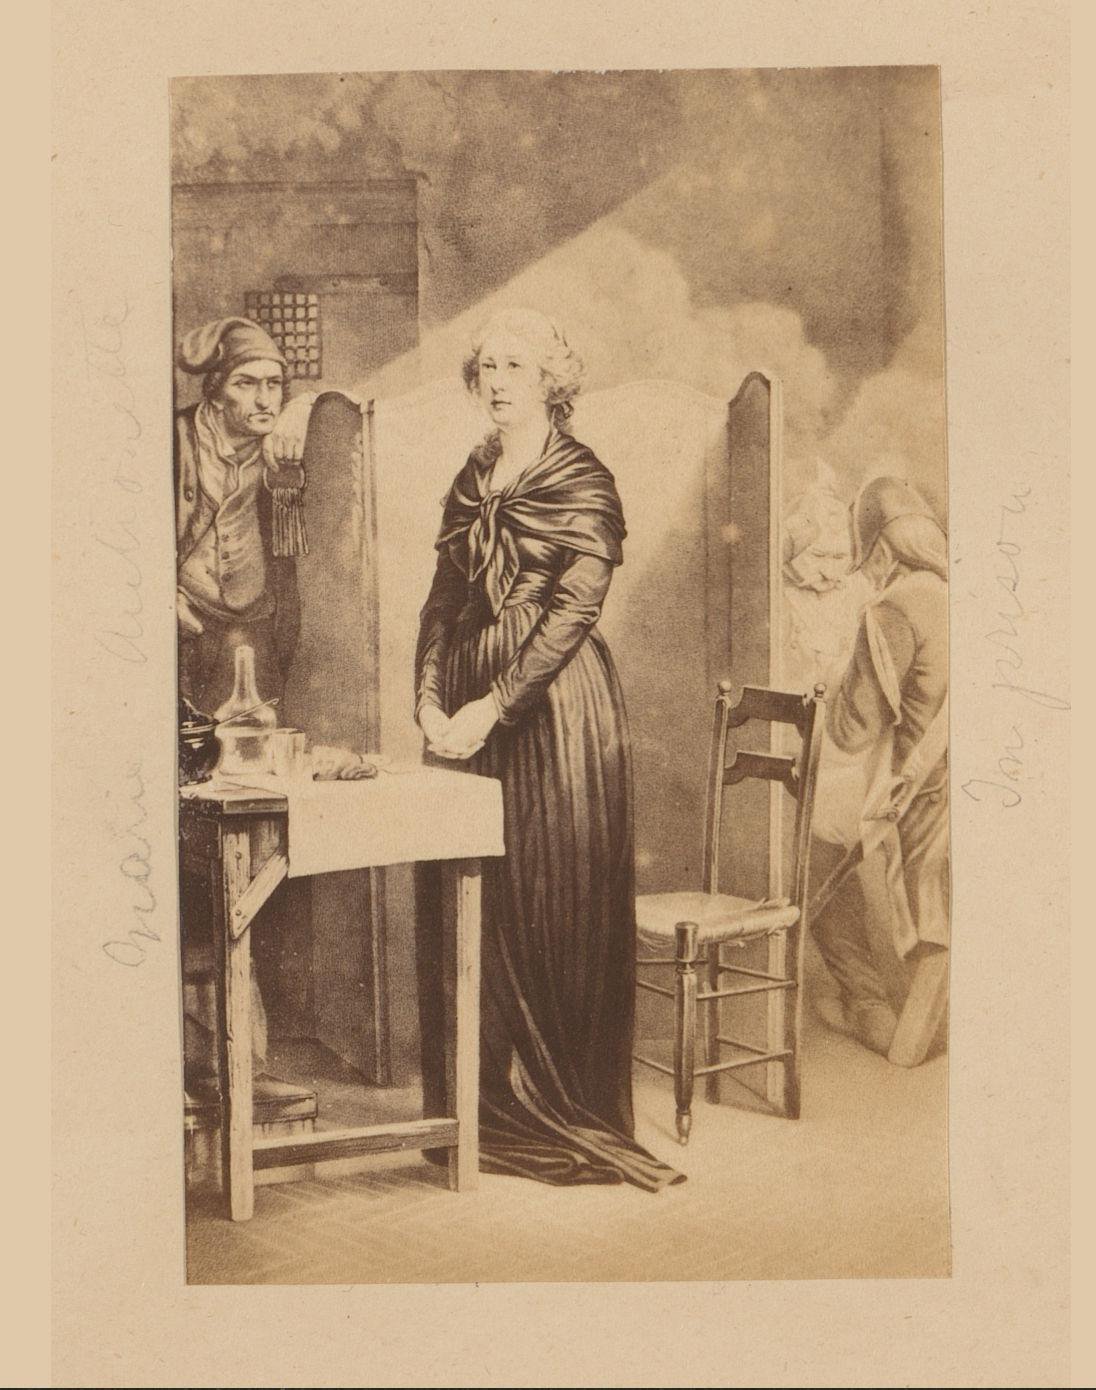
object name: album leaf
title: Fotoreproductie van een schilderij met Marie Antoinette in de gevangenis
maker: Anonymous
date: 1875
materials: paper, photographic support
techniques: albumen print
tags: vienna, paris, marie antoinette, prison, jail, queen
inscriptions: annotation: ‘Marie Antoinette/ In prison’